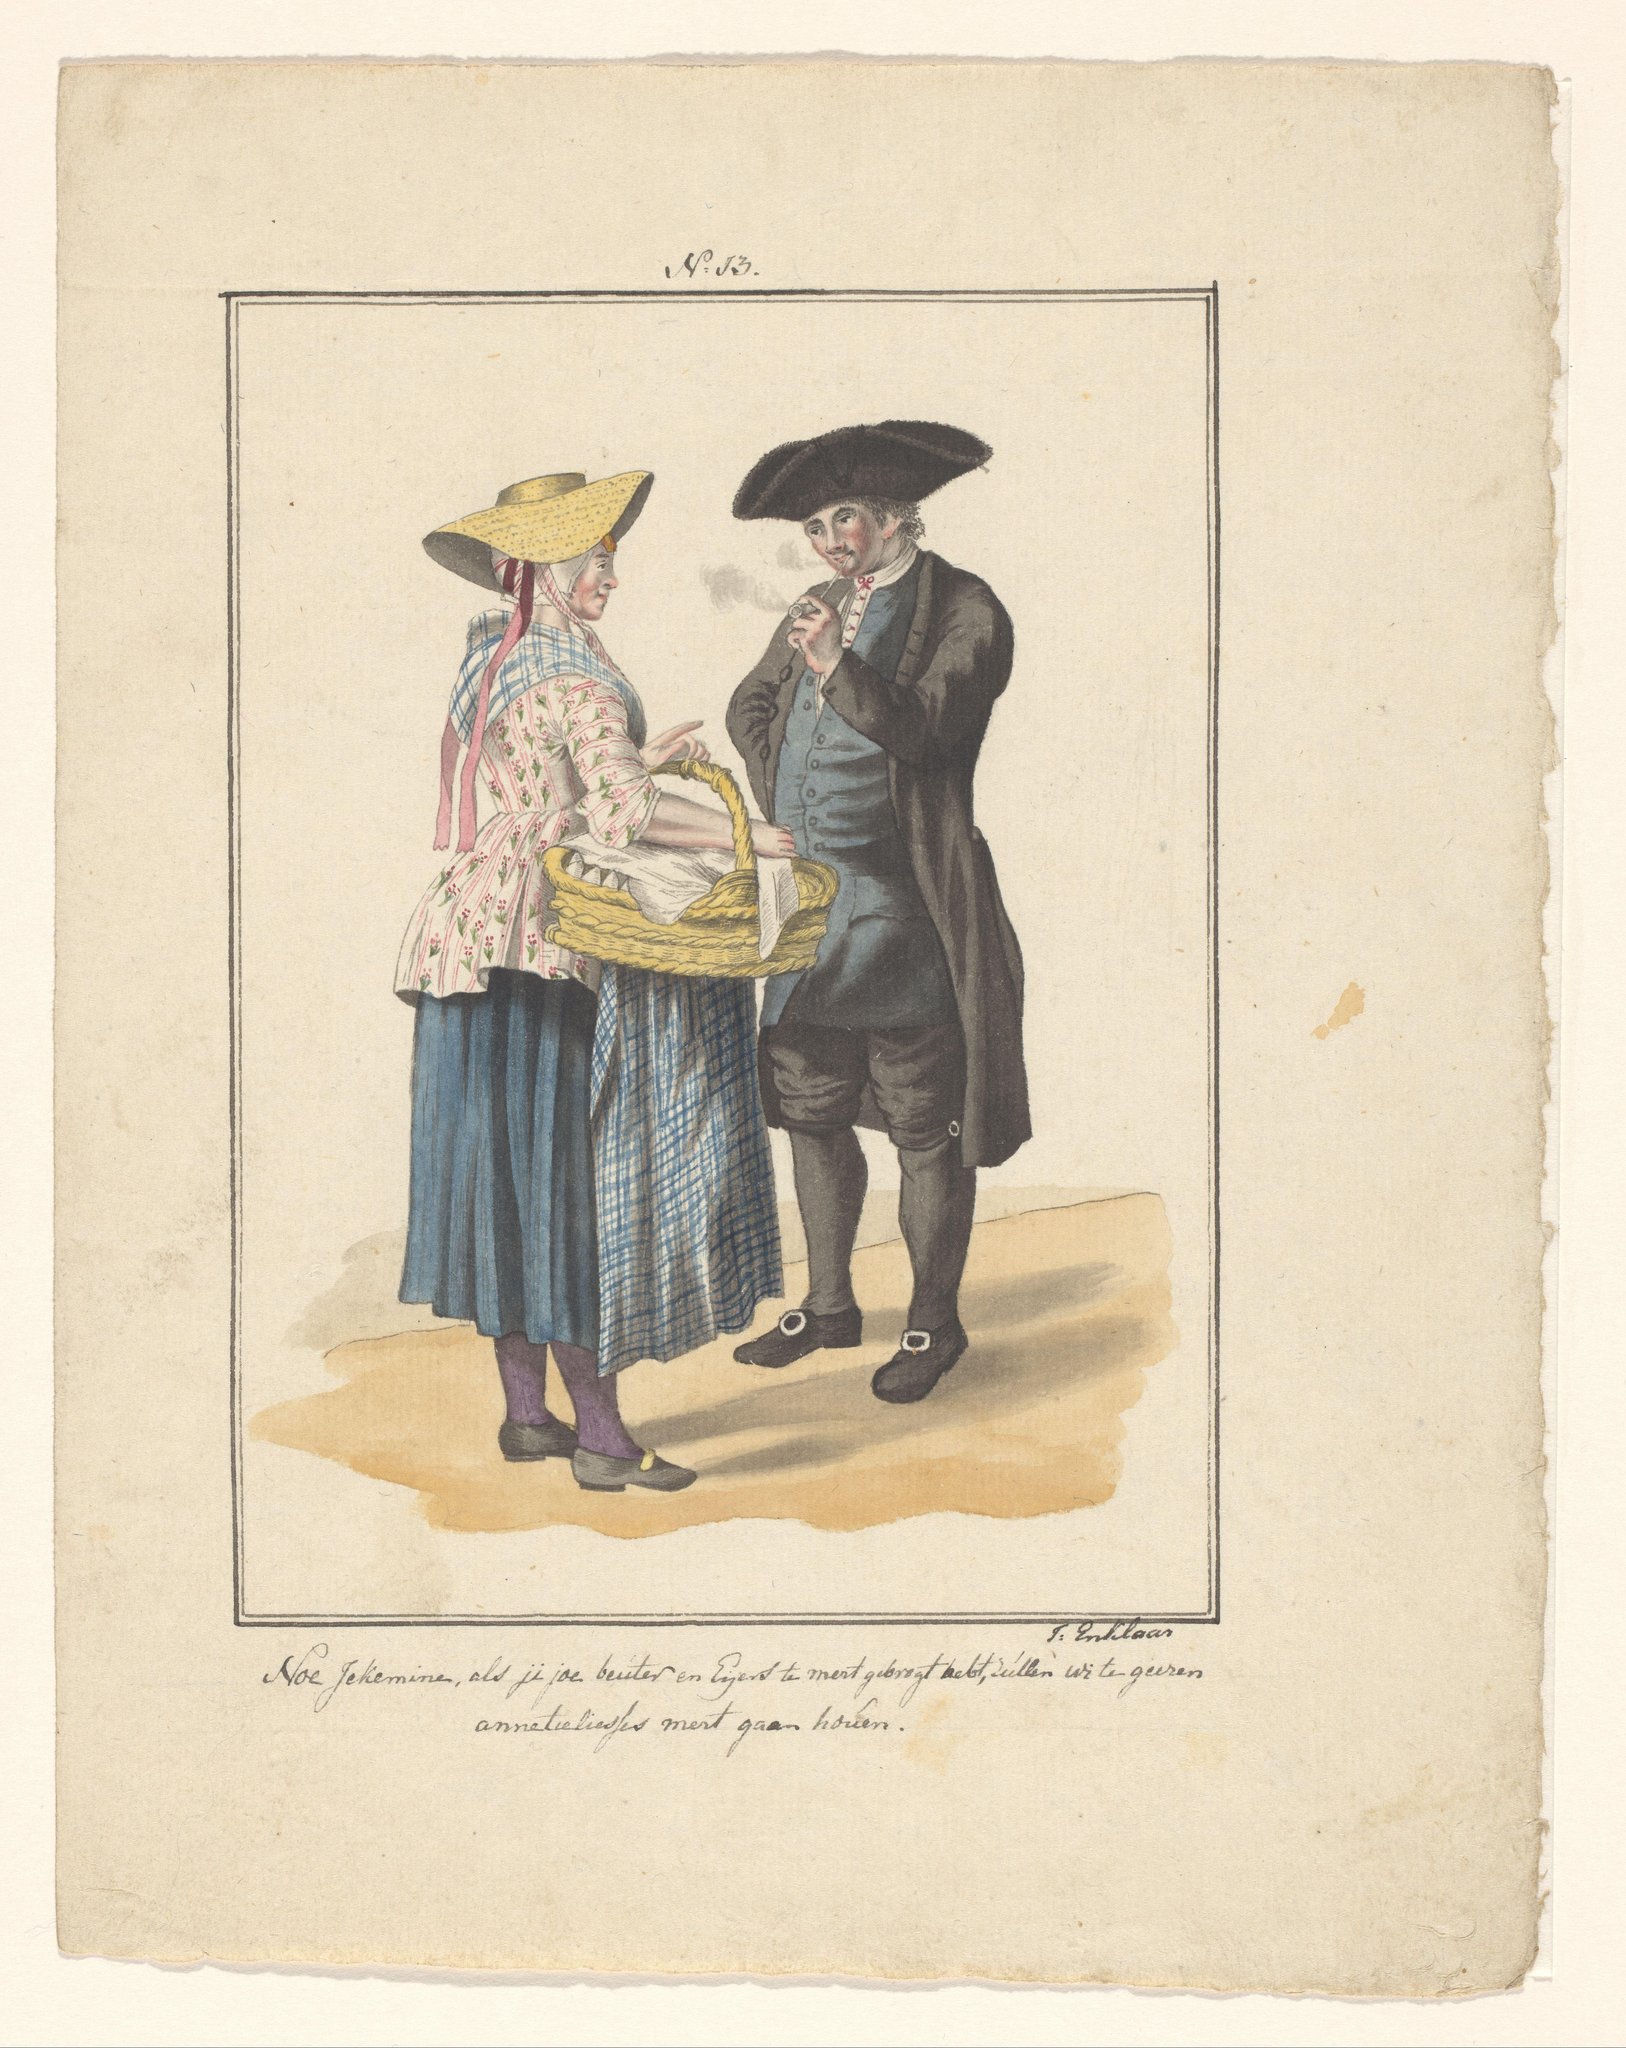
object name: drawing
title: Noe, Jekemine, als ji joe beuter en eijers te mert gebregt hebt, zullen wi te geeren annetieliesjes mert gaan houen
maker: j. enklaar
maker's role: draughtsman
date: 1803-1899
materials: ink, paper, watercolor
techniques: brush, pen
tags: carrying something in basket, bag, rucksack, etc., folk costume, regional costume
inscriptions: number: ‘No: 13.’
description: Getekend naar prenten uit: Maaskamp, Evert. Afbeeldingen van de kleeding, zeden en gewoonten in de Bataafsche Republiek, met den aanvang der negentiende eeuw. Amsterdam: Evert Maaskamp, [1803-1807].